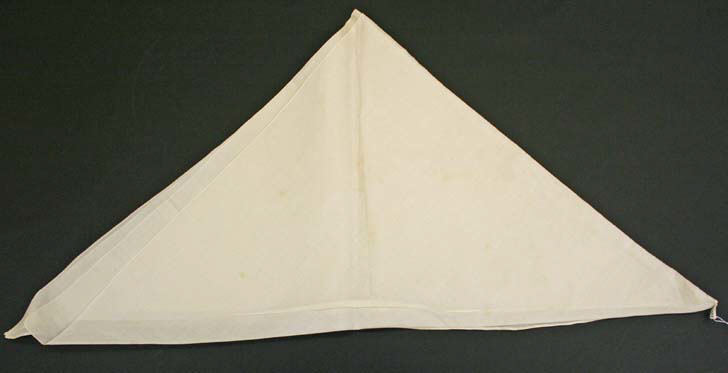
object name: neckerchief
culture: american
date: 1701-1800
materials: linen